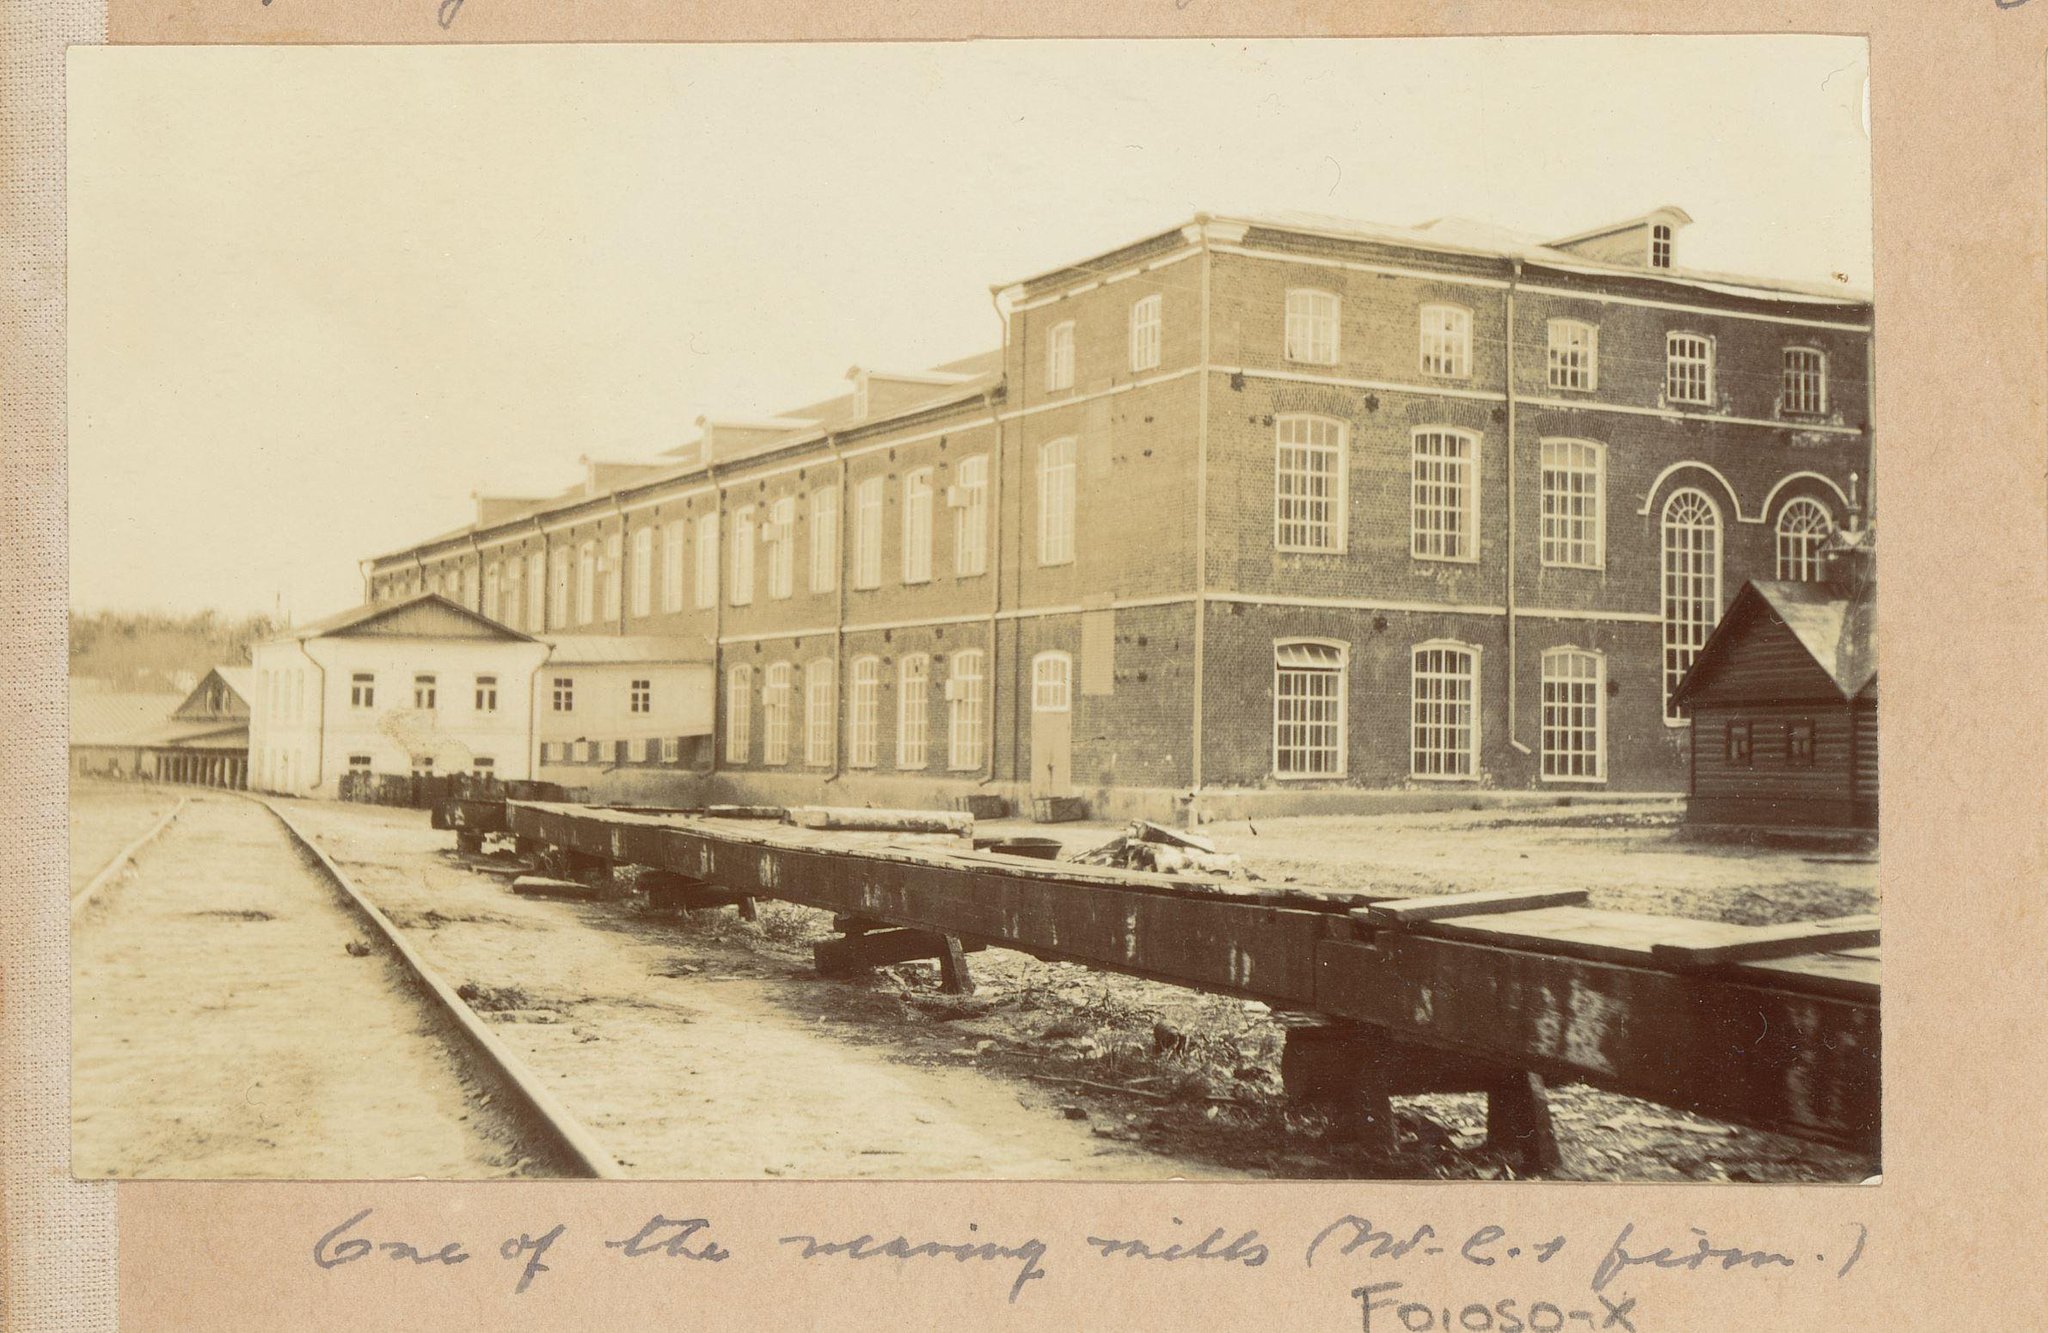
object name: photograph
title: Exterieur van één van de weverijen van Joseph Cheetham in Rusland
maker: joseph cheetham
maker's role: engineer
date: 1903-1904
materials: photographic support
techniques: gelatin silver print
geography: russia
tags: factory-building, russia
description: Onderdeel van Fotoalbum van de Engelse familie Cheetham met opnames van hun verblijf in Rusland.